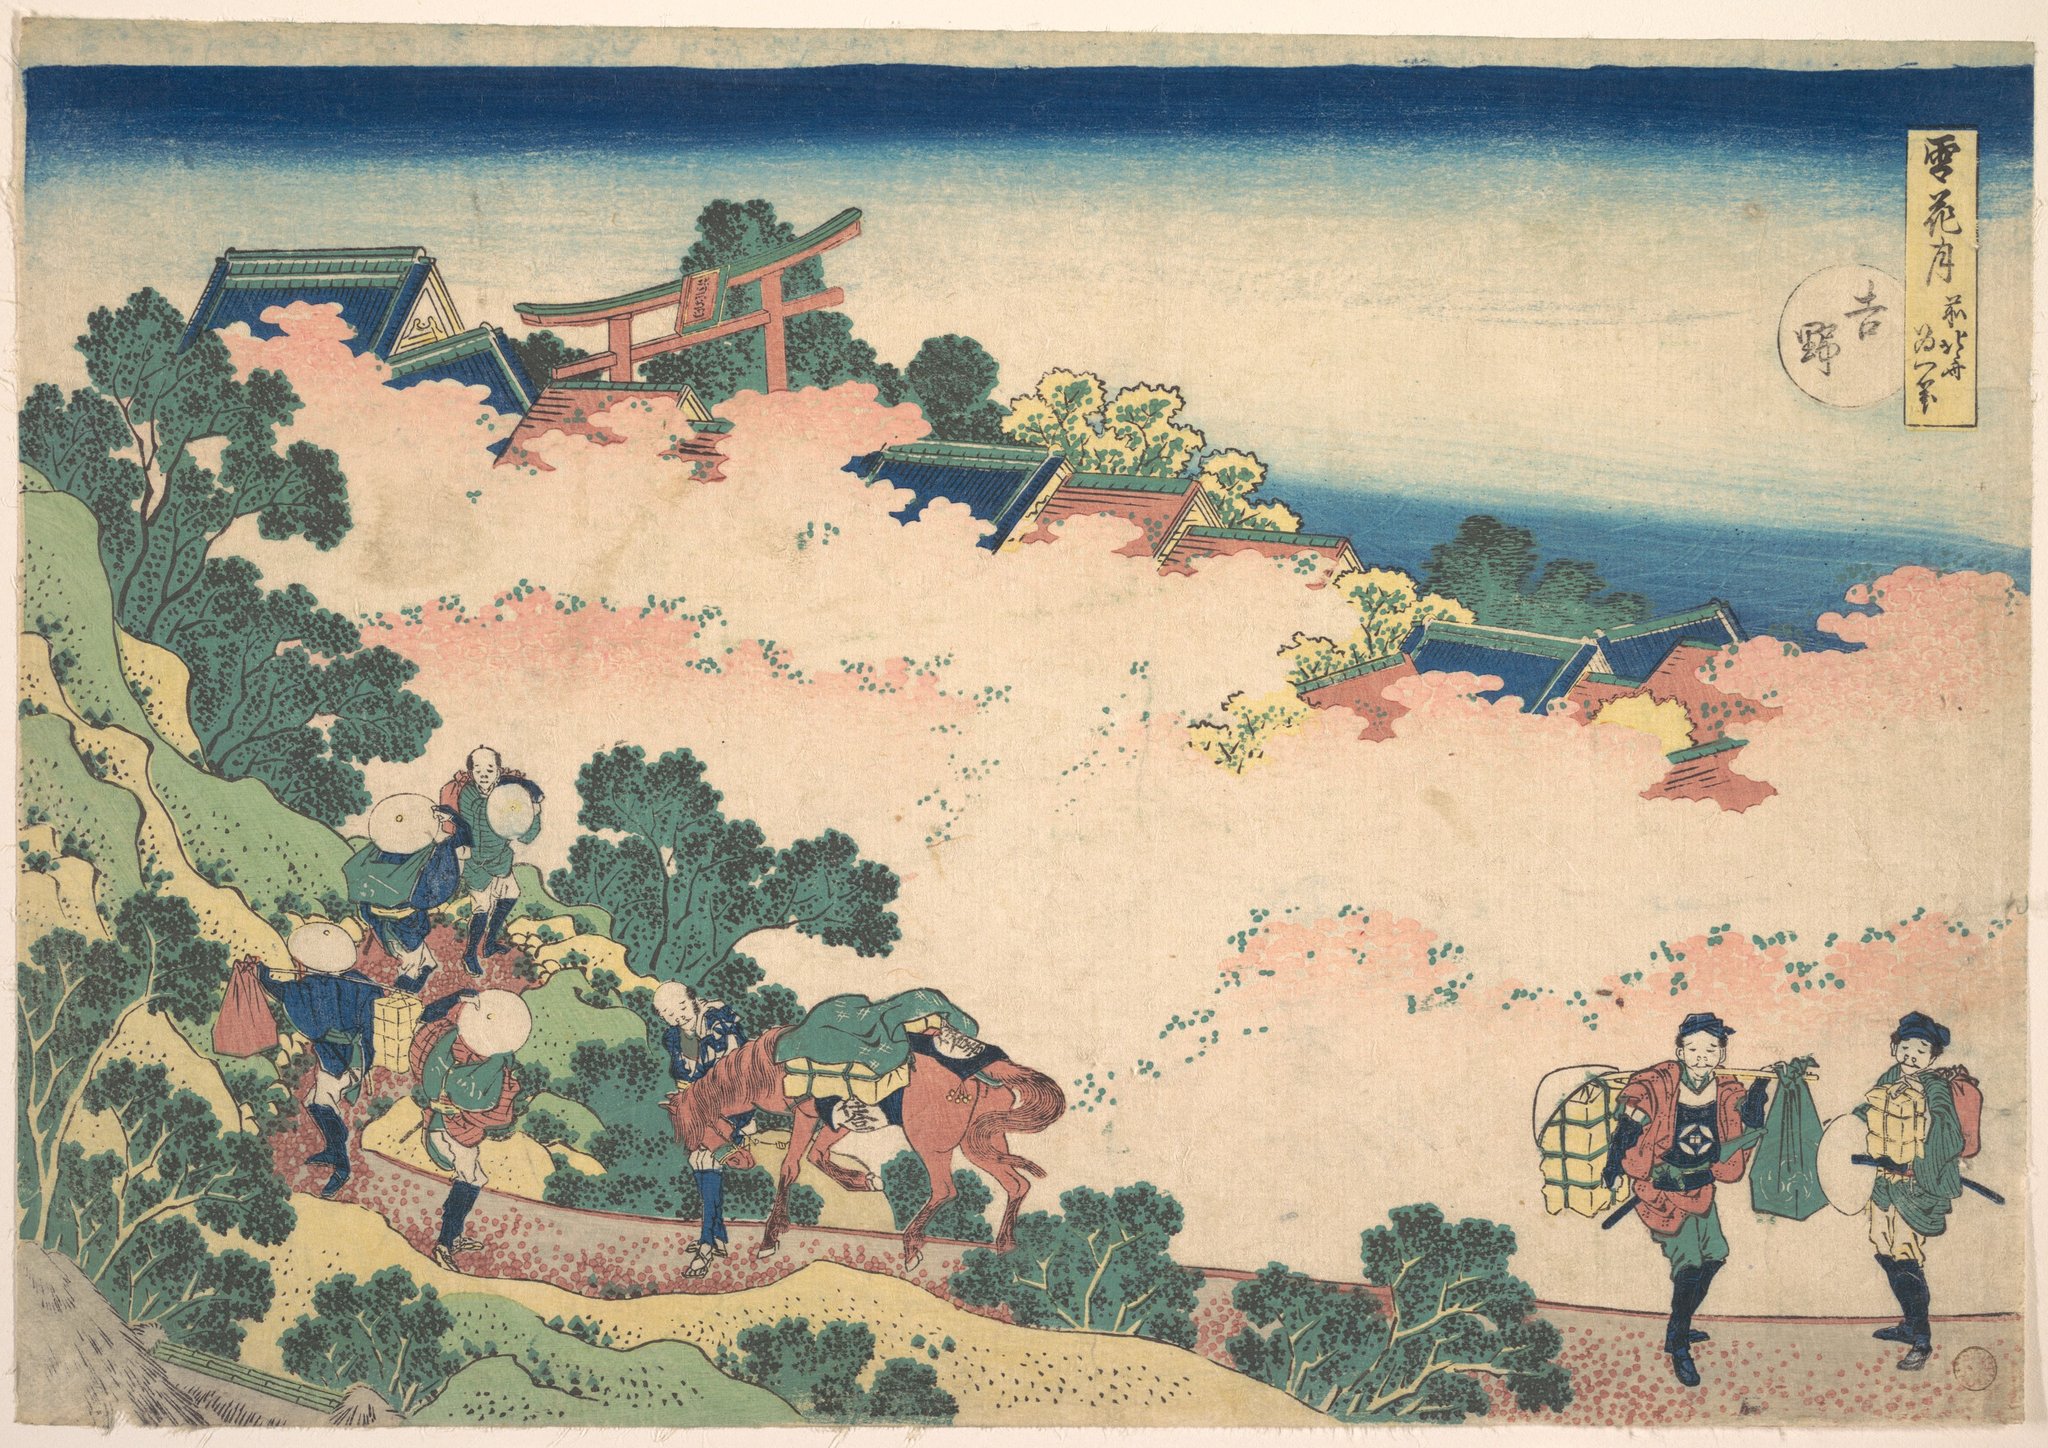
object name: woodblock print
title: Cherry Blossoms at Yoshino (Yoshino), from the series Snow, Moon, and Flowers (Setsugekka)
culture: japanese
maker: katsushika hokusai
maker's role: artist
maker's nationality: japanese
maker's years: 1760-1849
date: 1833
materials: ink, paper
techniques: woodblock print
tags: houses,men,horses,moon,trees